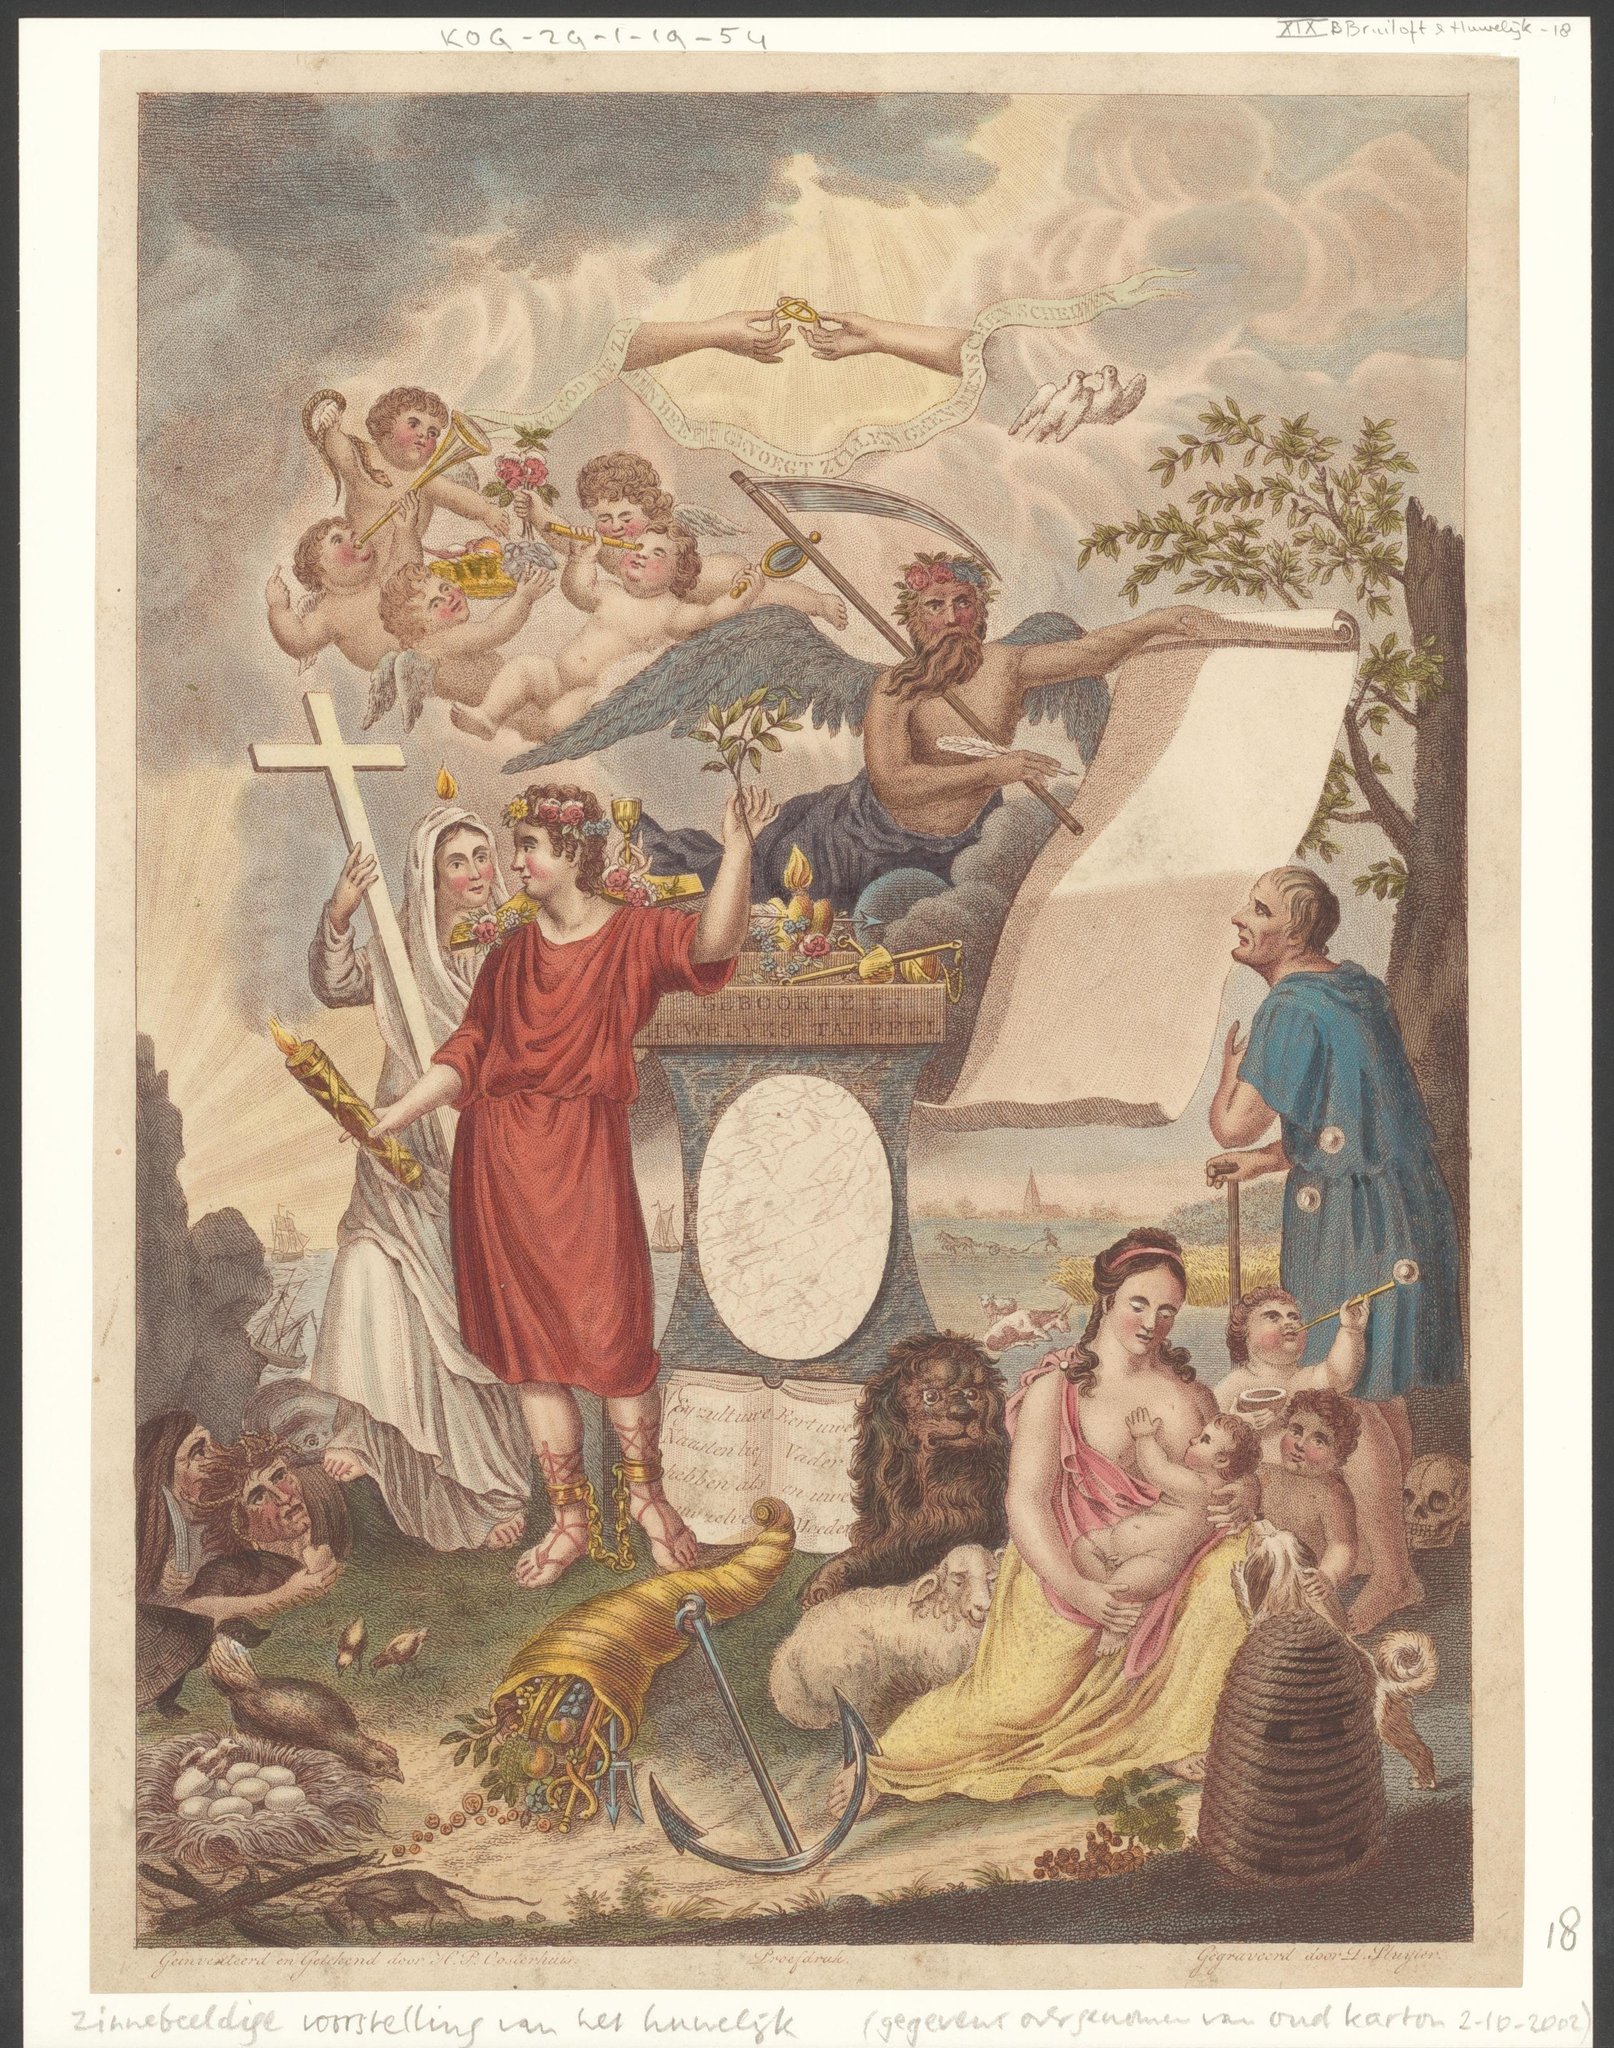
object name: print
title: Bruiloftsprent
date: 1800-1810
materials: paper, watercolor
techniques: hand coloring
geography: netherlands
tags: faith, 'fides'; 'fede', 'fede catholica', 'fede christiana', 'fede christiana catholica' (ripa) ~ one of the three theological virtues, nursing, suckling, 'vanitas' symbols, (civil) marriage ceremonies, father time, man with wings and scythe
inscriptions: collector's mark, collector's mark: Lugt 1641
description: Bruiloftsprent met een allegorische voorstelling met de bruidegom als vader staande bij Geloof en de bruid als moeder zittend op de grond haar kind zogend naast de leeuw en het lam. Op het huwelijksaltaar zit Vader Tijd met een blanco papierrol. Met andere symbolische elementen en personificaties. Mogelijk bedoeld als wensbrief, om door een kind aangeboden te worden aan zijn ouders. Onderwerpsrubrieken binnen de Atlas Zeden en Gewoonten: Des Menschen Begin, Midden en Einde. Bruiloft en huwelijk.